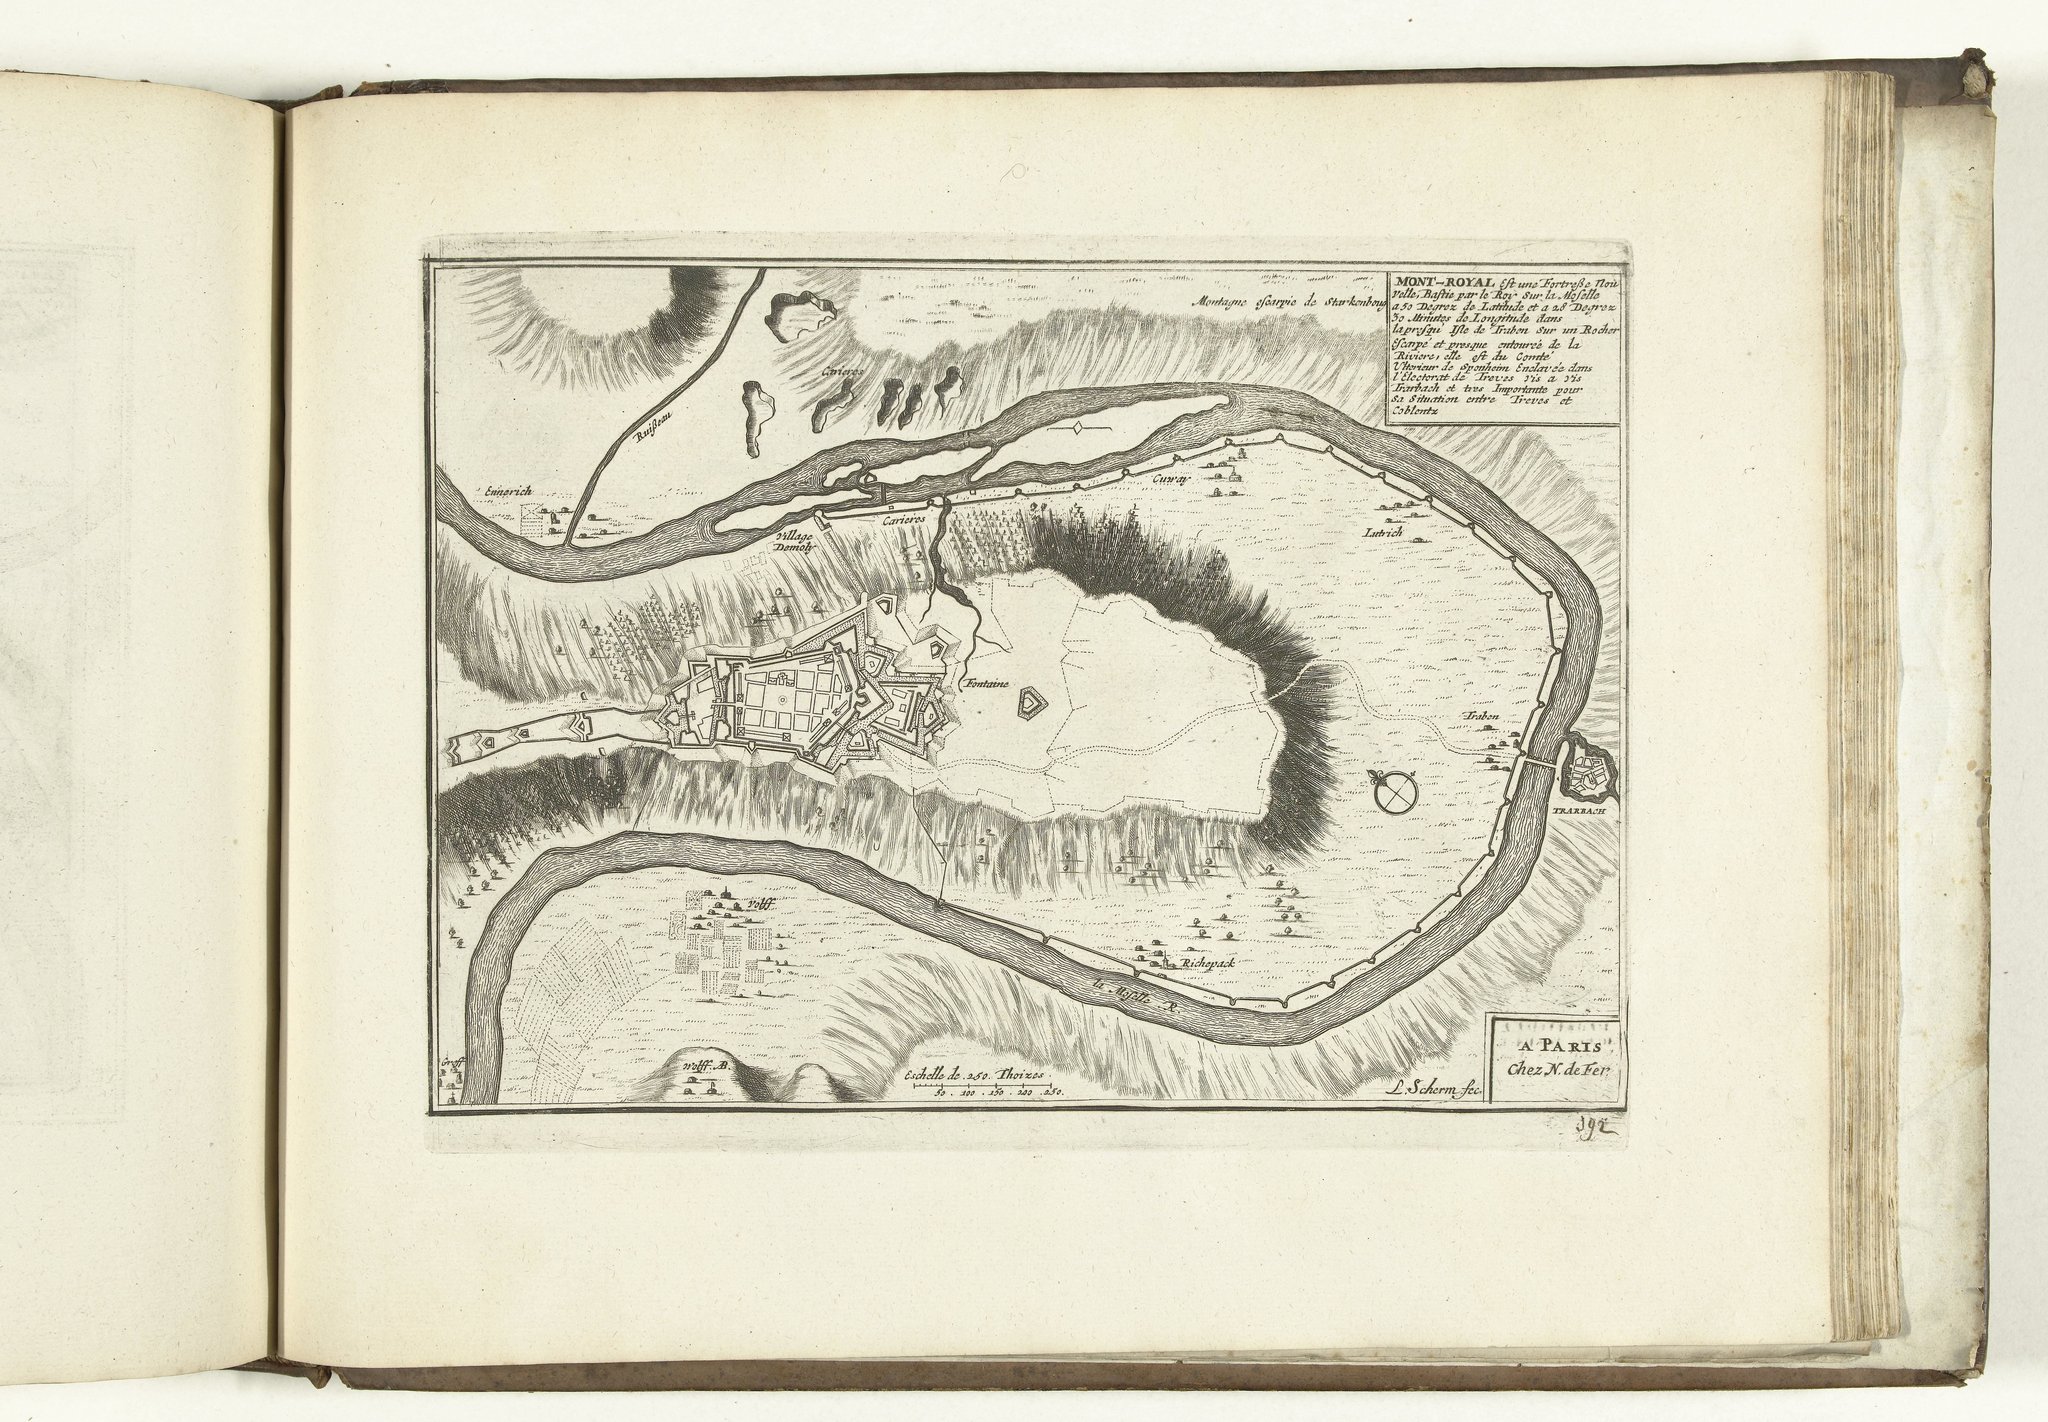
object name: print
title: Mont-Royal Est une Fortresse Nouvelle (...)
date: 1726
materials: paper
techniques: etching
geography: leiden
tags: fortress, maps of cities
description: Plattegrond van het fort Mont Royal in een bocht van de Mosel. Plaat nr. 192 in deel VIII van het prentwerk: Les Forces de l'Europe, Asie, Afrique et Amerique ... Comme aussi les Cartes des Côtes de France et d'Espagne uit 1726, dit eerste deel met 238 met de hand genummerde platen van vermaarde sterke steden en vestingen in het kader van de Spaanse Successieoorlog 1701-1713. Voor het merendeel zijn deze platen gekopieerd naar de anonieme Franse platen van vermaarde sterke steden en vestingen: in Les forces de l'Europe en in: Le theatre de la guerre, dans les Pays-Bas, beide oorspronkelijk uitgegeven door Nicolas de Fer te Parijs (1693-1697) in het kader van de Negenjarige Oorlog. Titel en opschriften in het Frans.